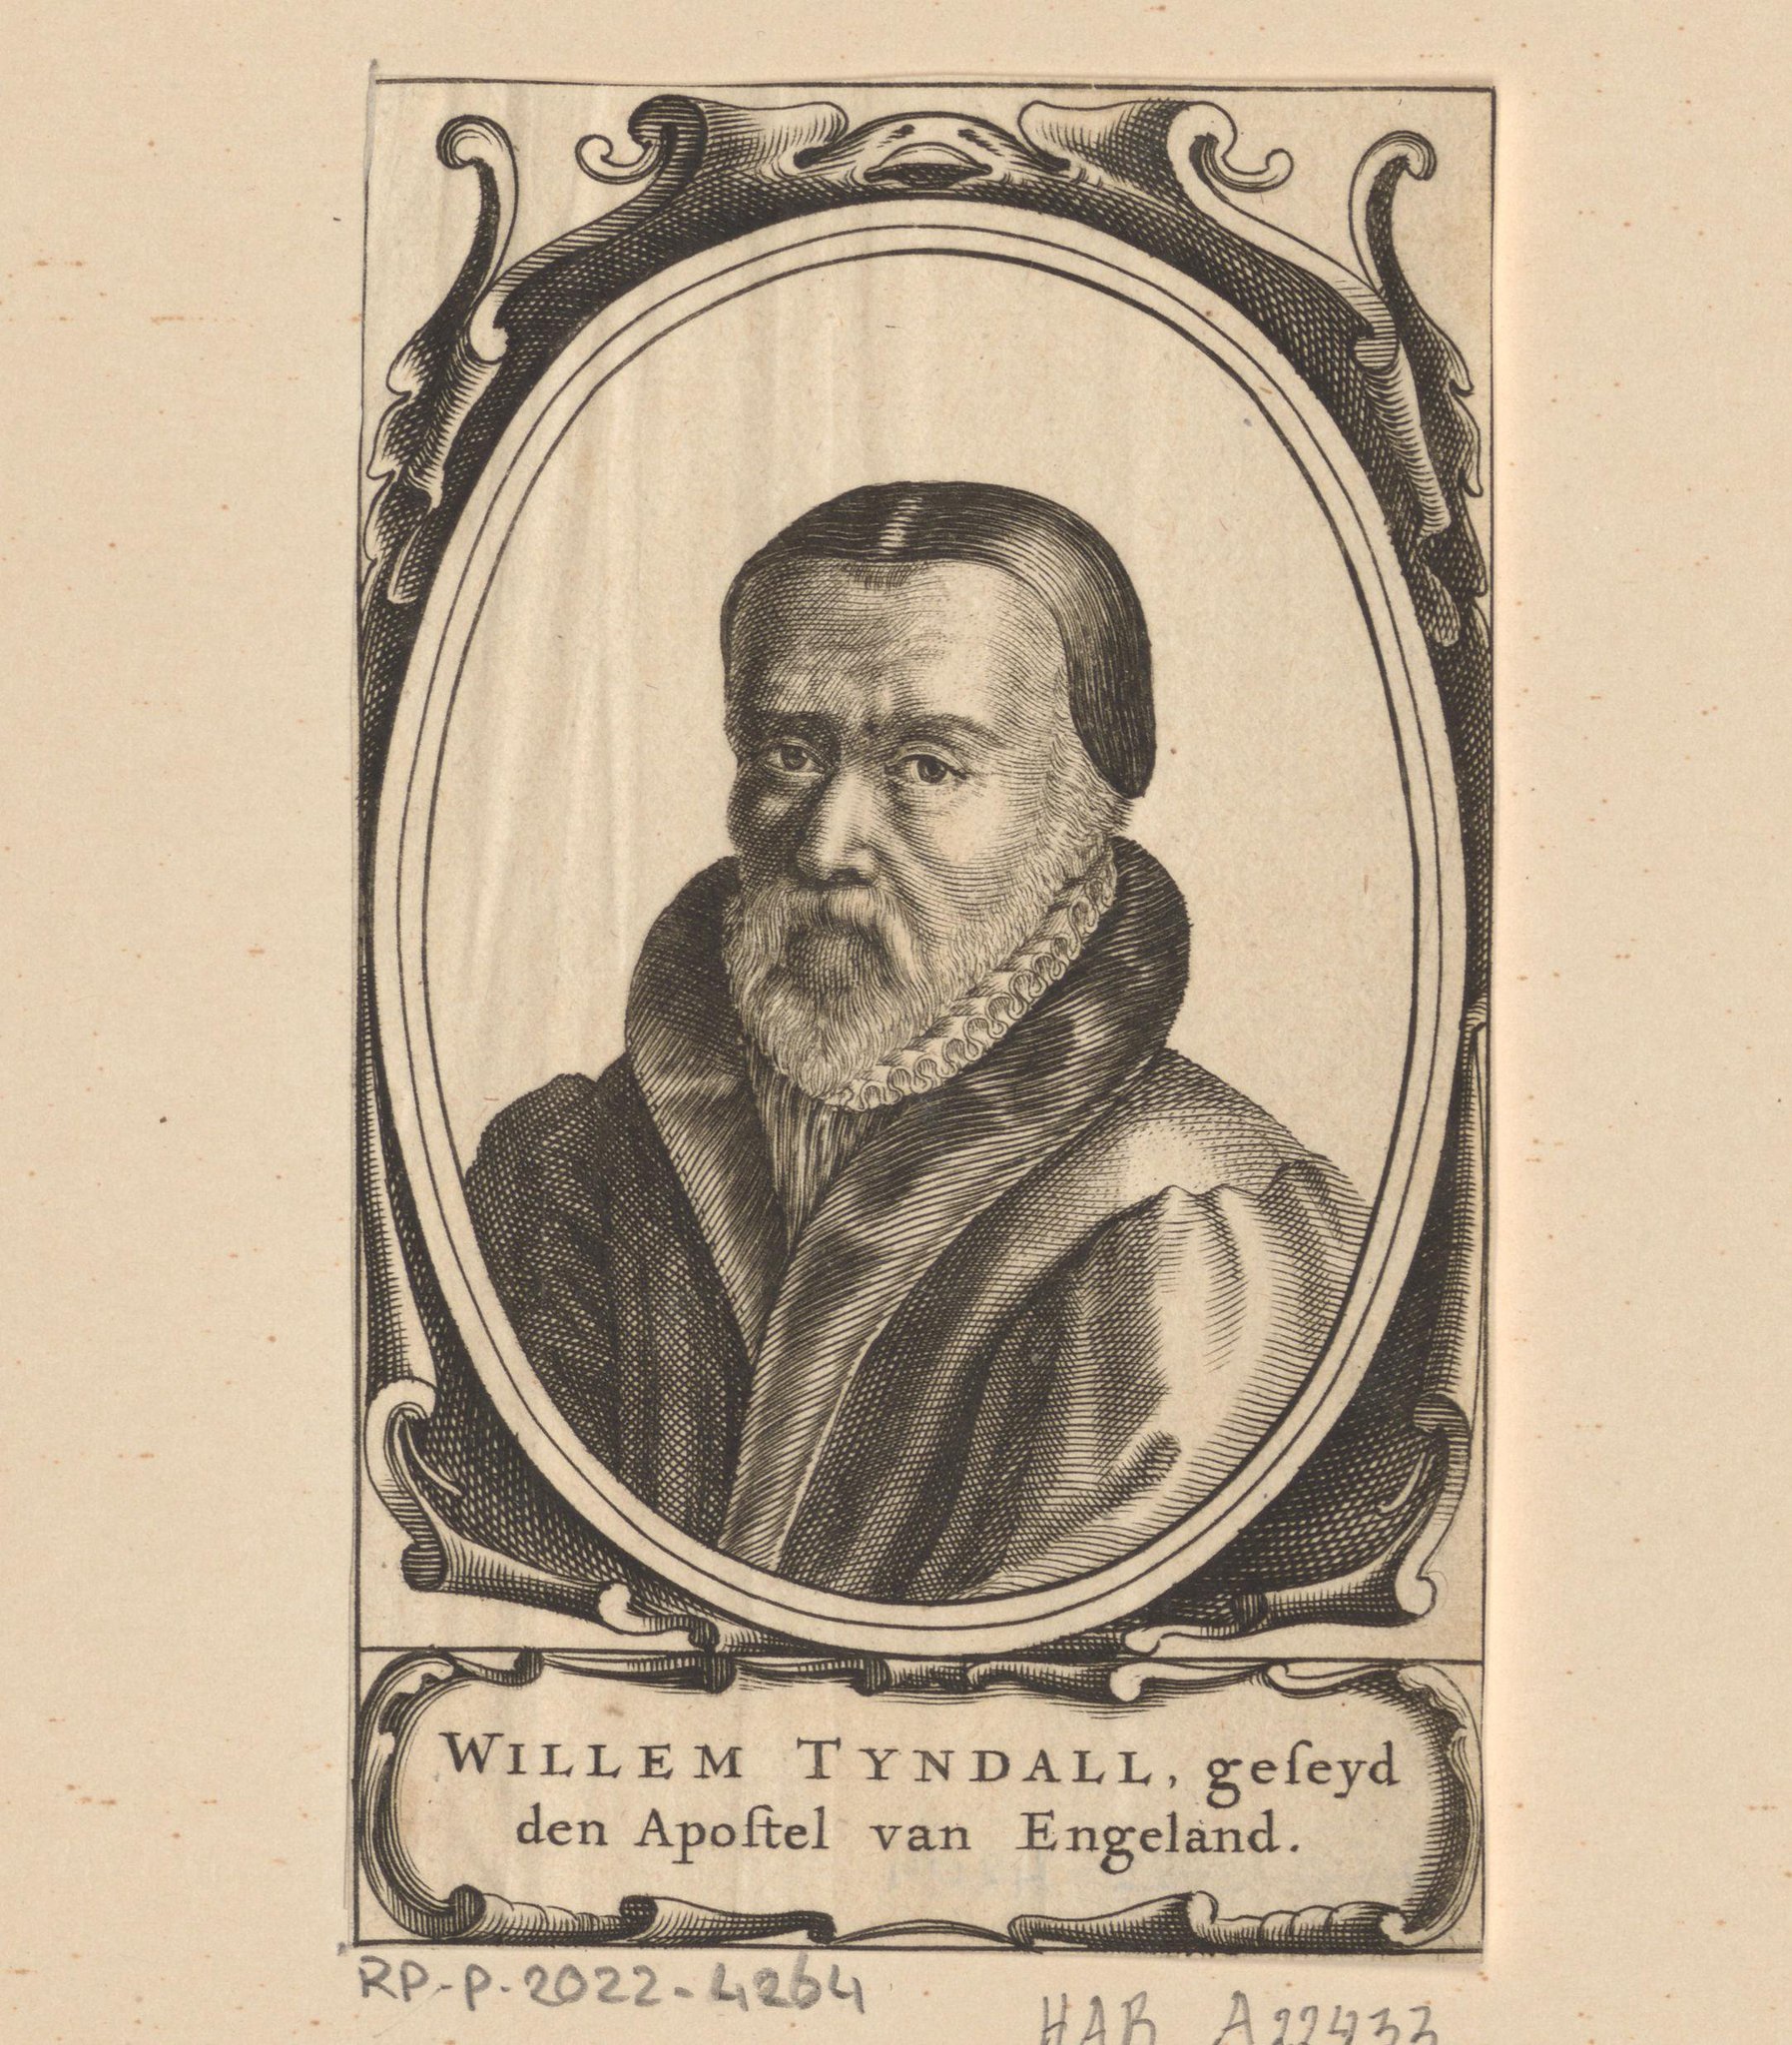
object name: print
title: Portret van William Tyndale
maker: Anonymous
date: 1659-1681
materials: paper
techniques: engraving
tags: theologian, historical persons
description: Prent waarschijnlijk uit: Corput, Abraham van den. De goddelicke vierschare, dat is ontdeckinge der hemelsche oordelen (…). Utrecht: Johannes Janssonius van Waesberge (I), 1659, dl. 1, p. 551. Prent ook gebruikt in de 1681 editie.